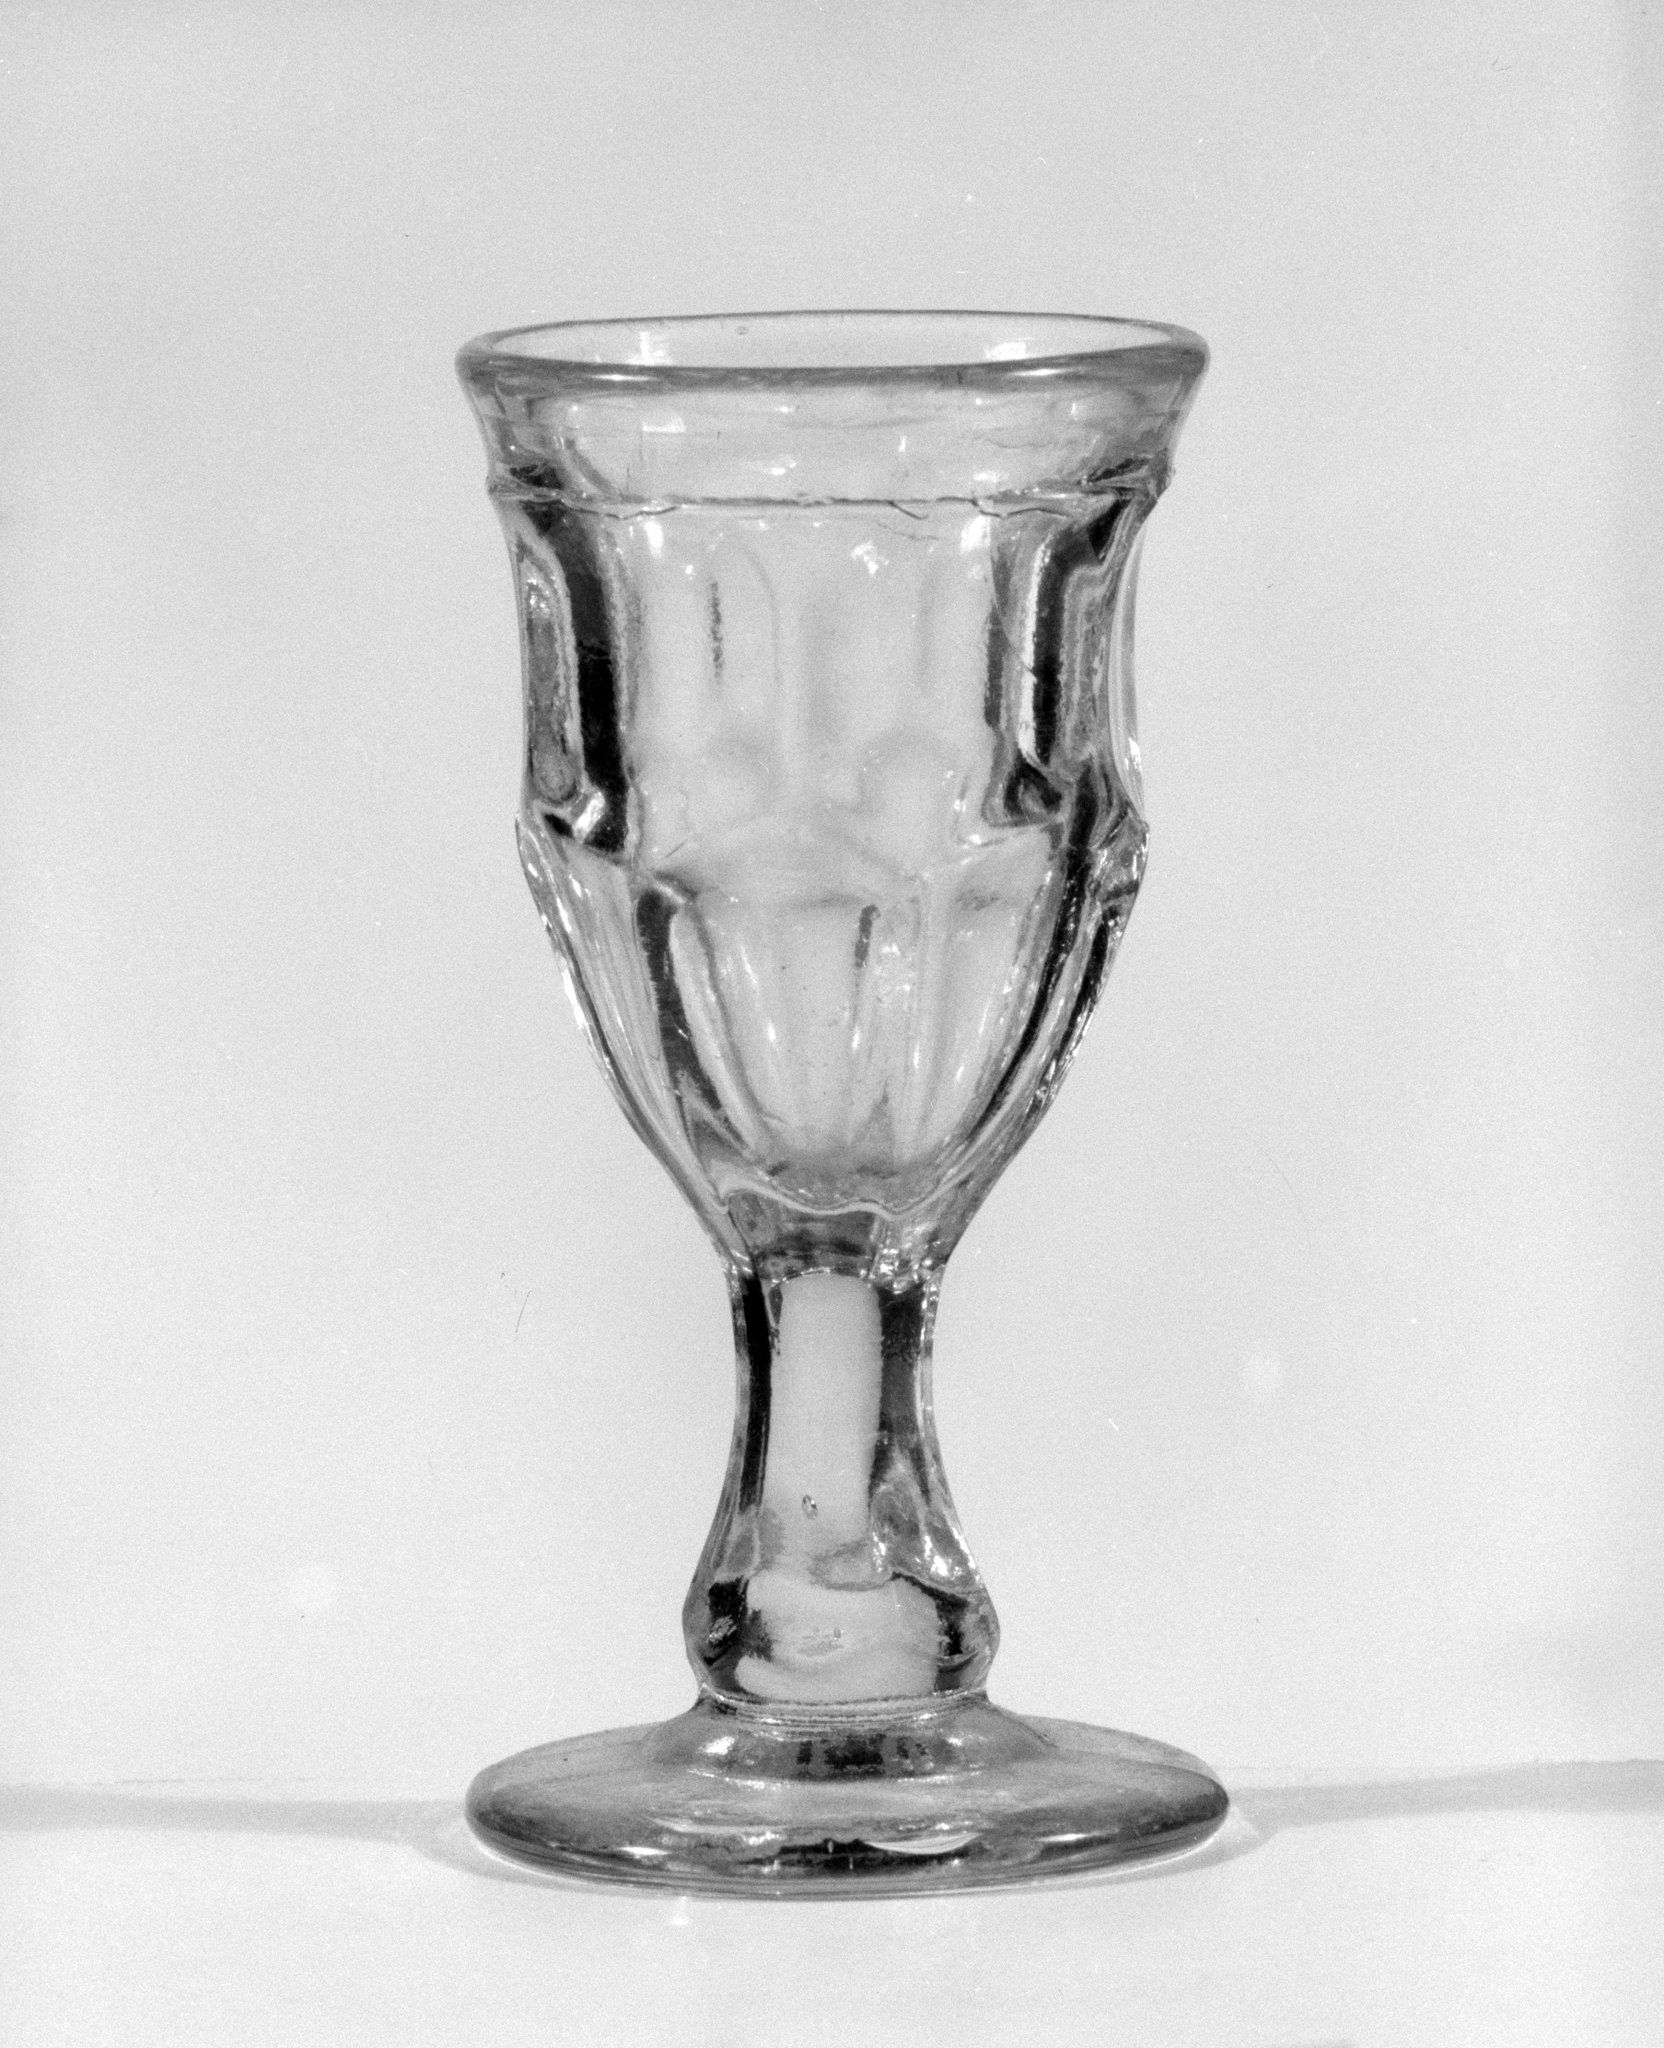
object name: cordial glass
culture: american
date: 1830-1870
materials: glass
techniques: pressed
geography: united states